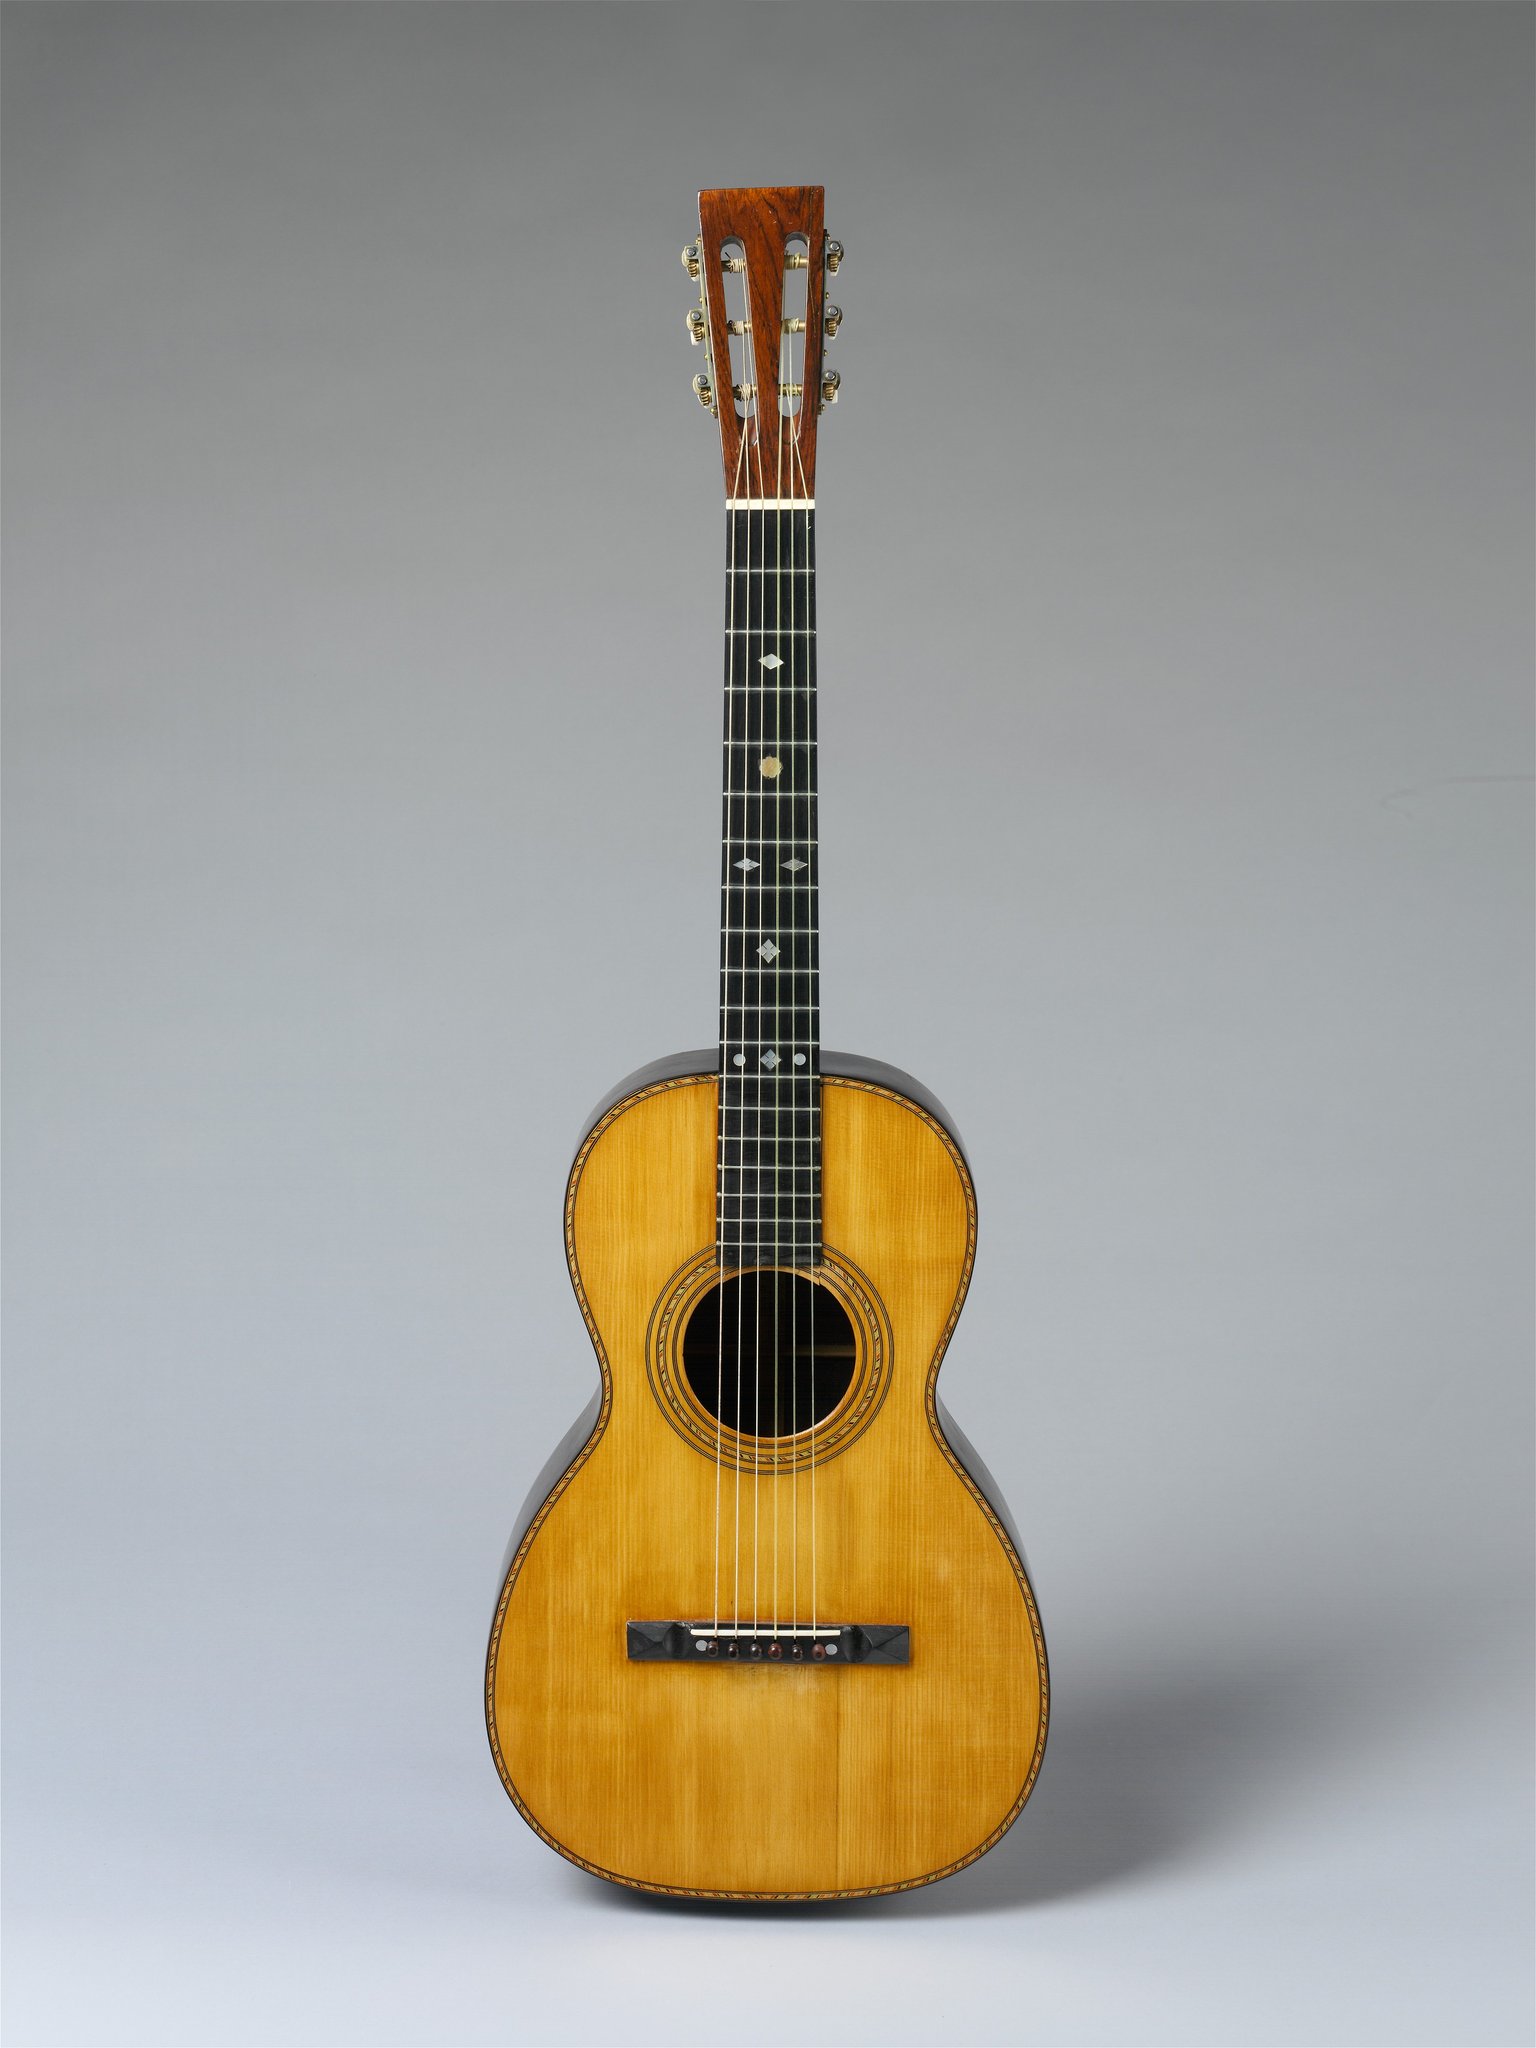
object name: guitar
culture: american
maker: joseph bini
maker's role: designer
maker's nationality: american, born italy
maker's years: 1810-1877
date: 1870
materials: wood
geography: united states